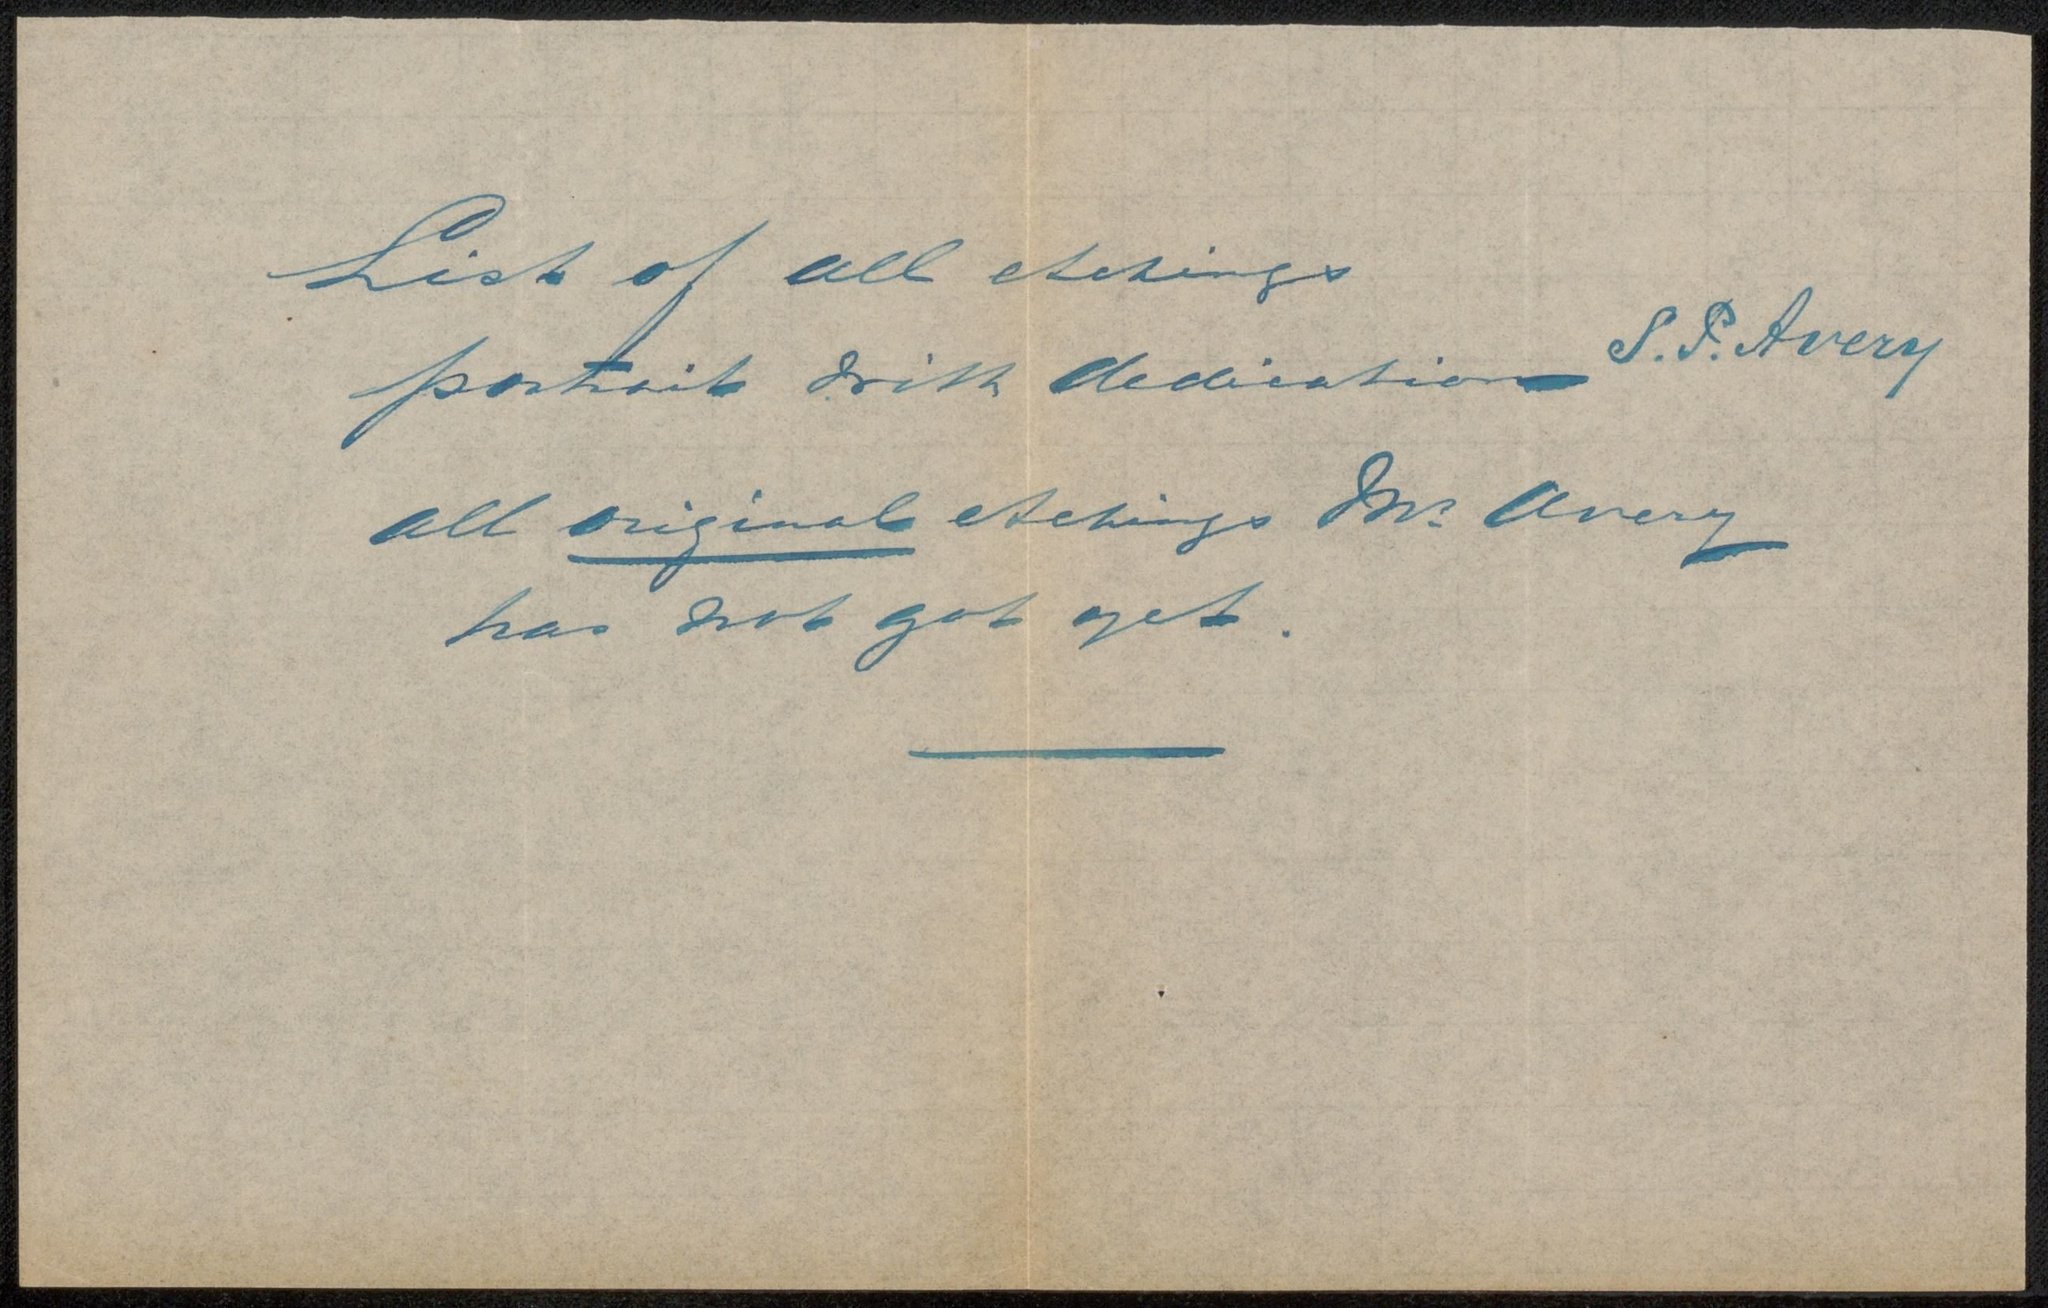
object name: aantekening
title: Aantekening uit archief Philip Zilcken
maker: hermanus gijsbertus tersteeg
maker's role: draughtsman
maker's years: 1845-1927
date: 1855-1904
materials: ink, paper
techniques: pen, writing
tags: new york (city), samuel putnam avery, the hague, painter, philip zilcken, the graphic arts, art collecting